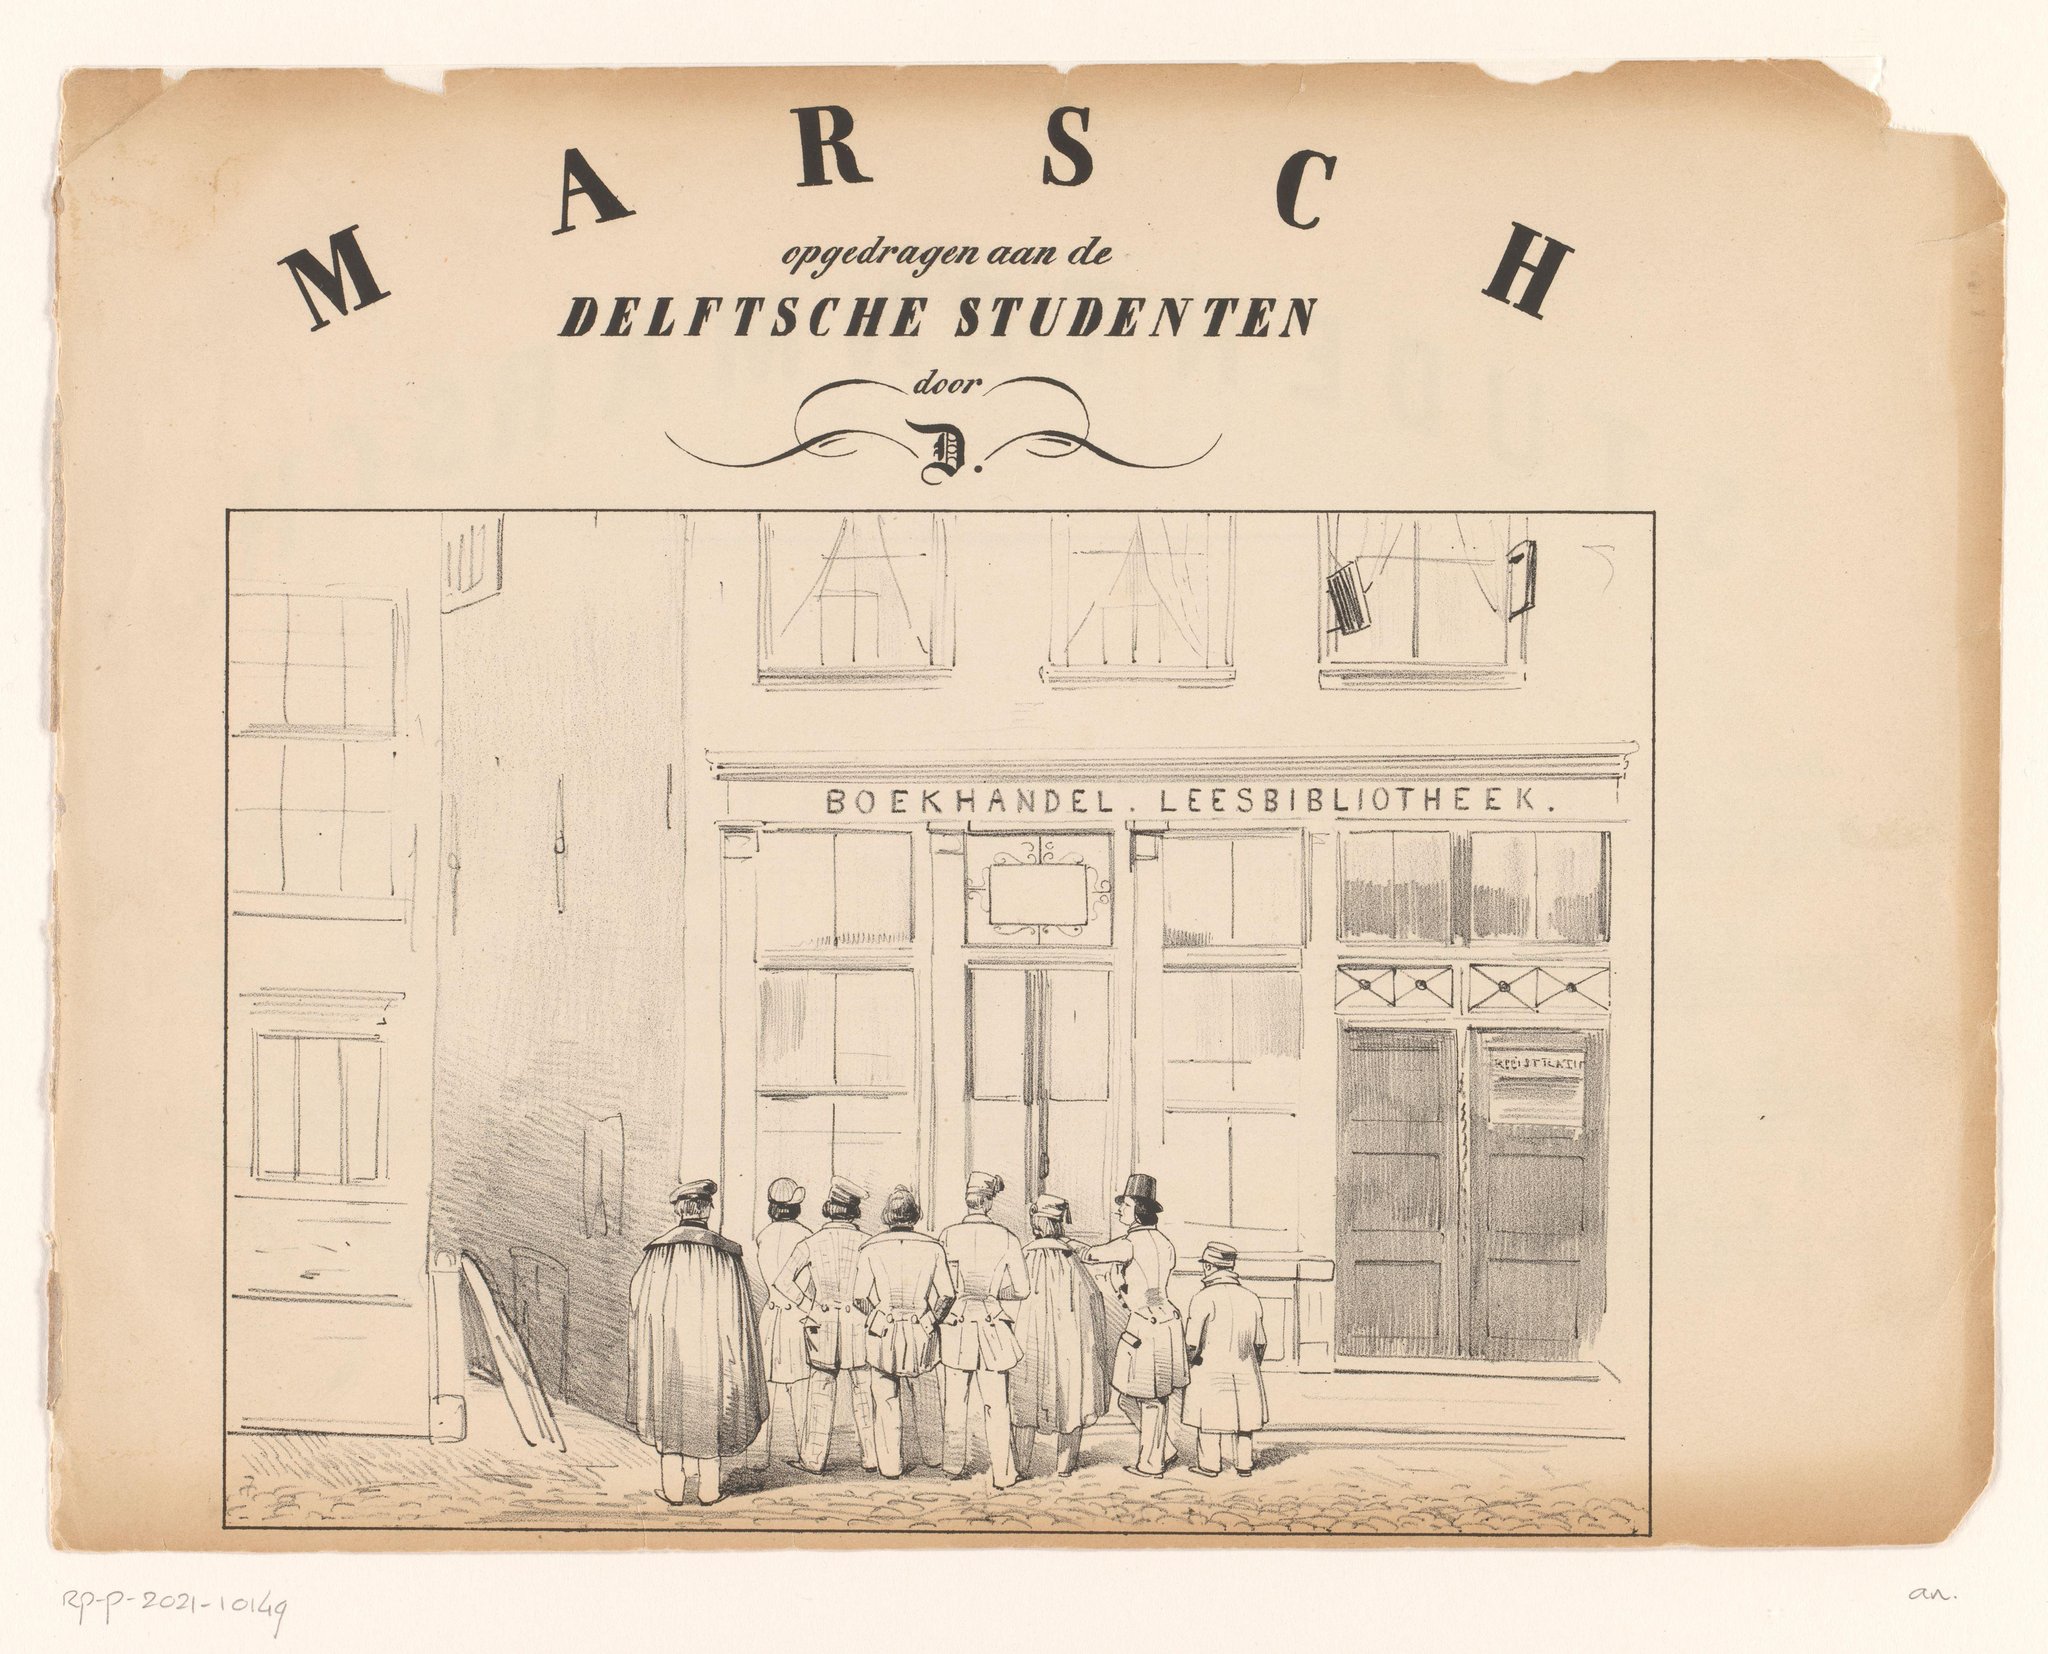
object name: print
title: Marsch opgedragen aan de Delftsche Studenten door D.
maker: Anonymous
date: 1850-1899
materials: paper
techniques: lithograph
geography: netherlands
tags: notation of music, student, book-shop, bookseller